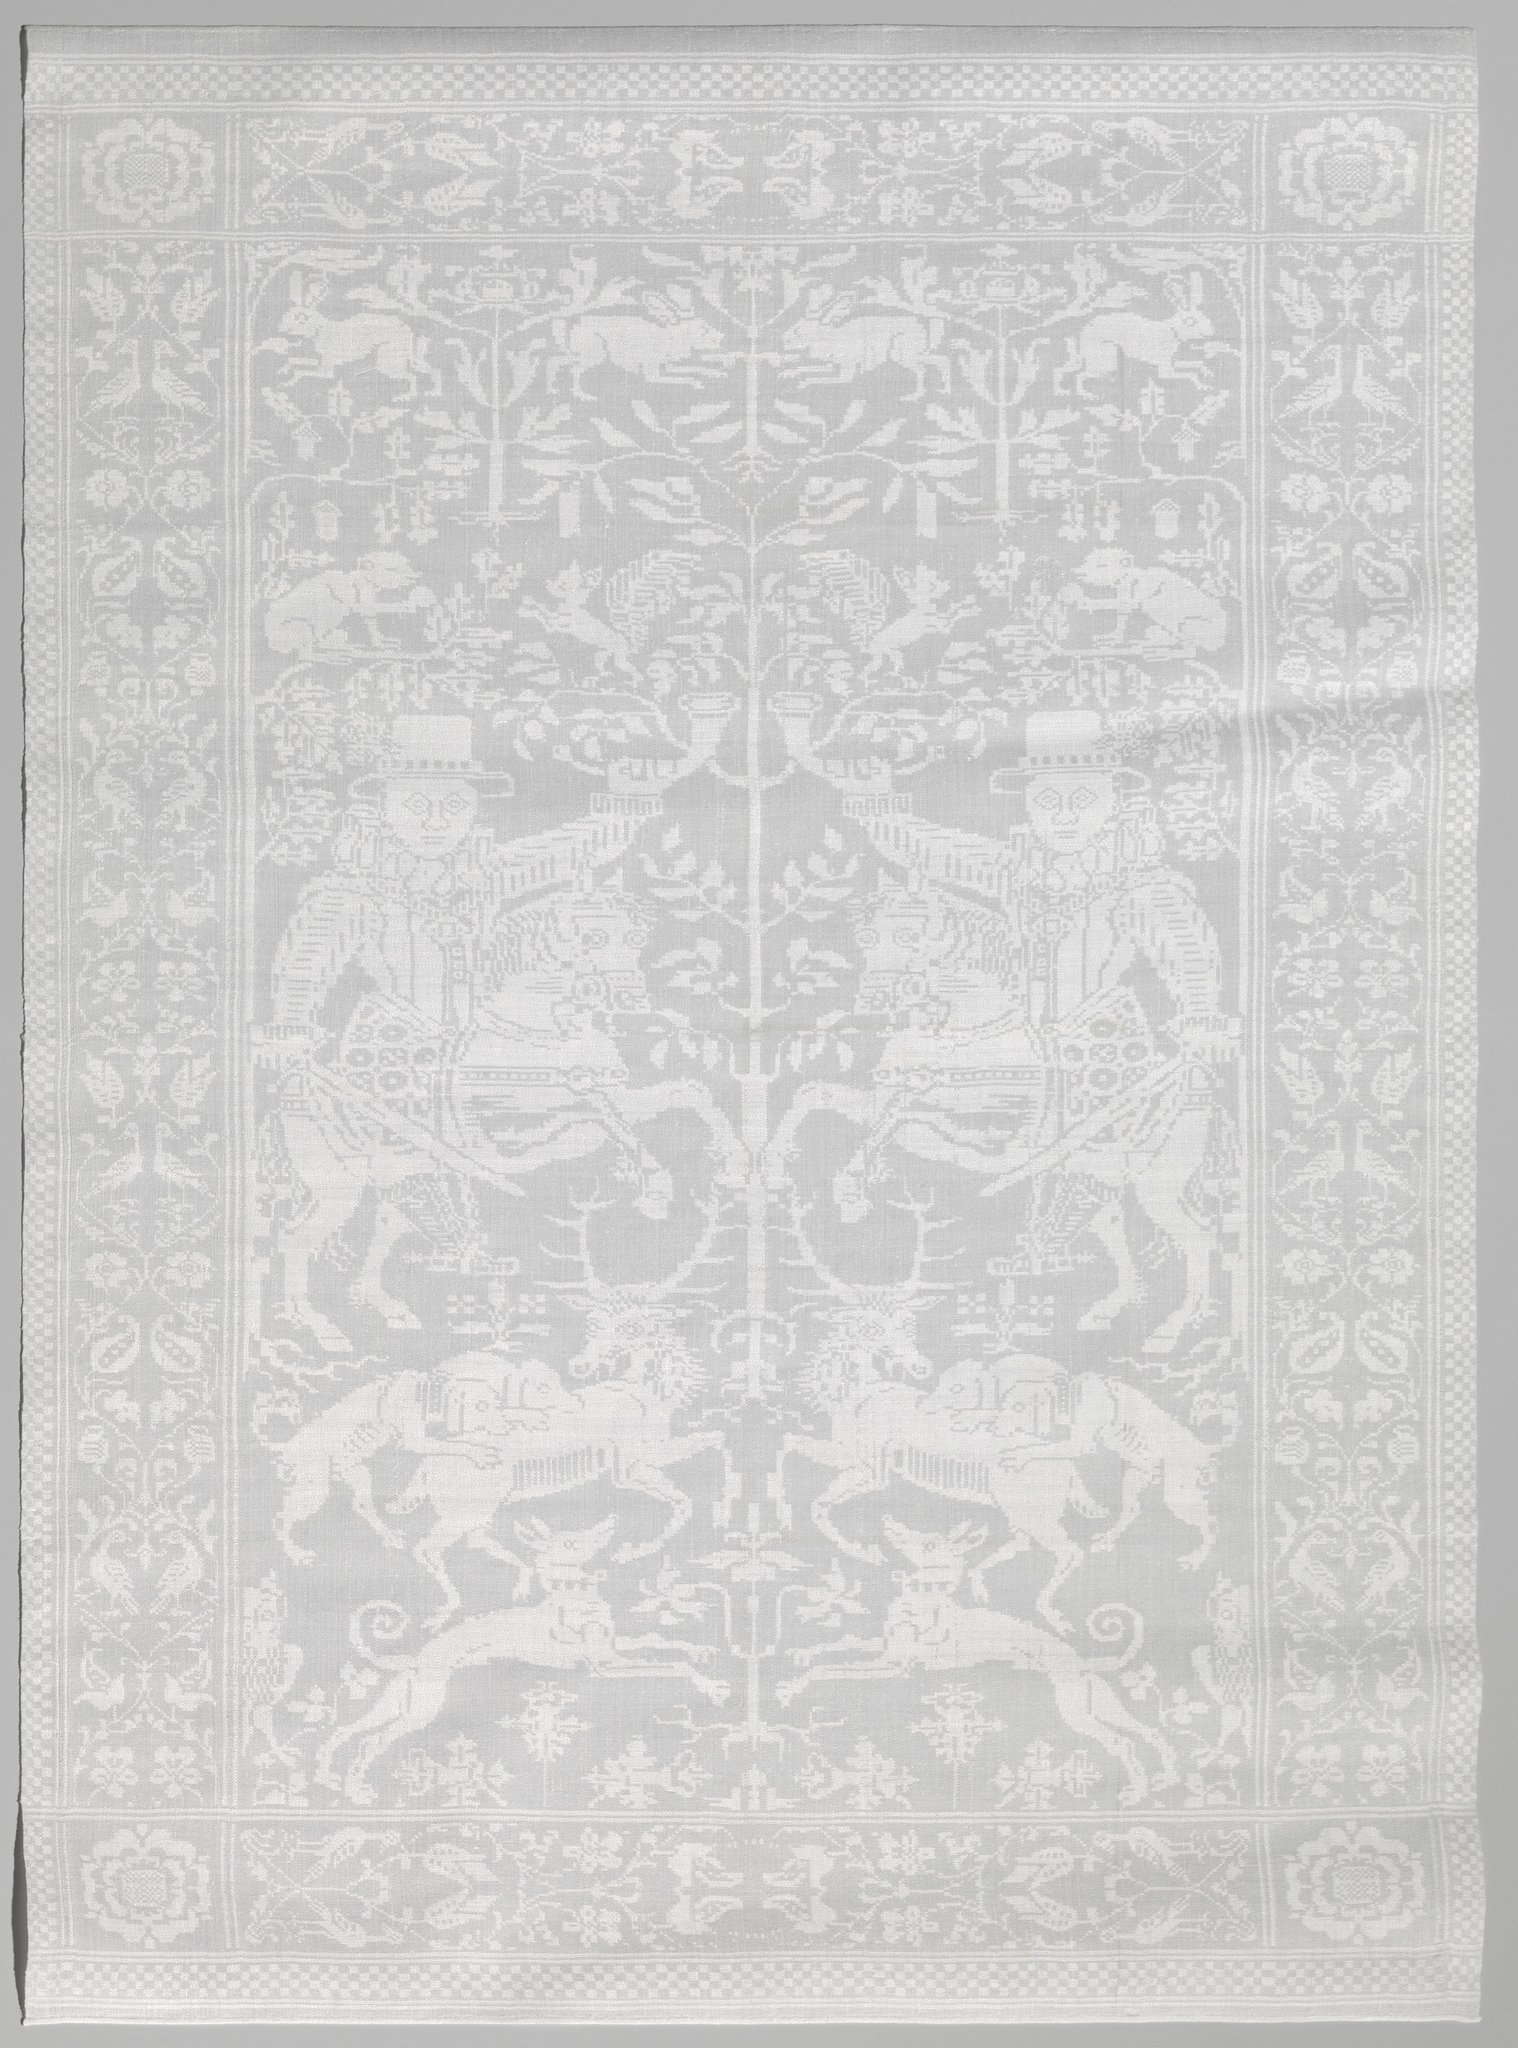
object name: napkin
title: Servet met voorstelling van een hertenjacht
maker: Anonymous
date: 1600-1625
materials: linen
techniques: damask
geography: northern netherlands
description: Servet van wit linnendamast met een hertenjacht.